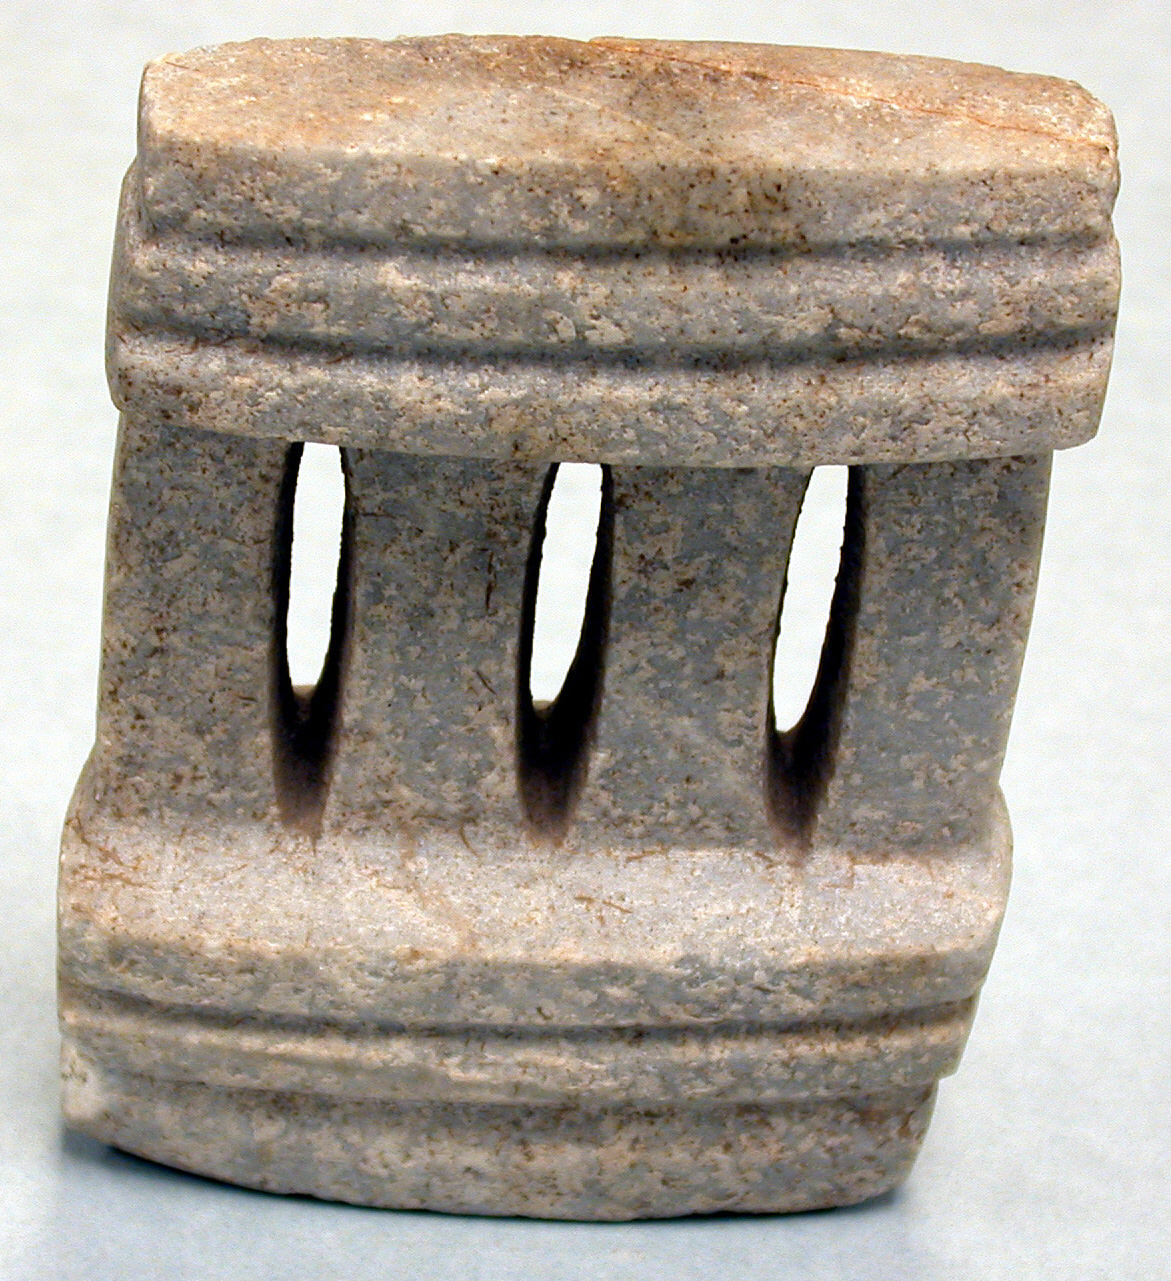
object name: architectural model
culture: mezcala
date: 1-800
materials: stone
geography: mexico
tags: temples